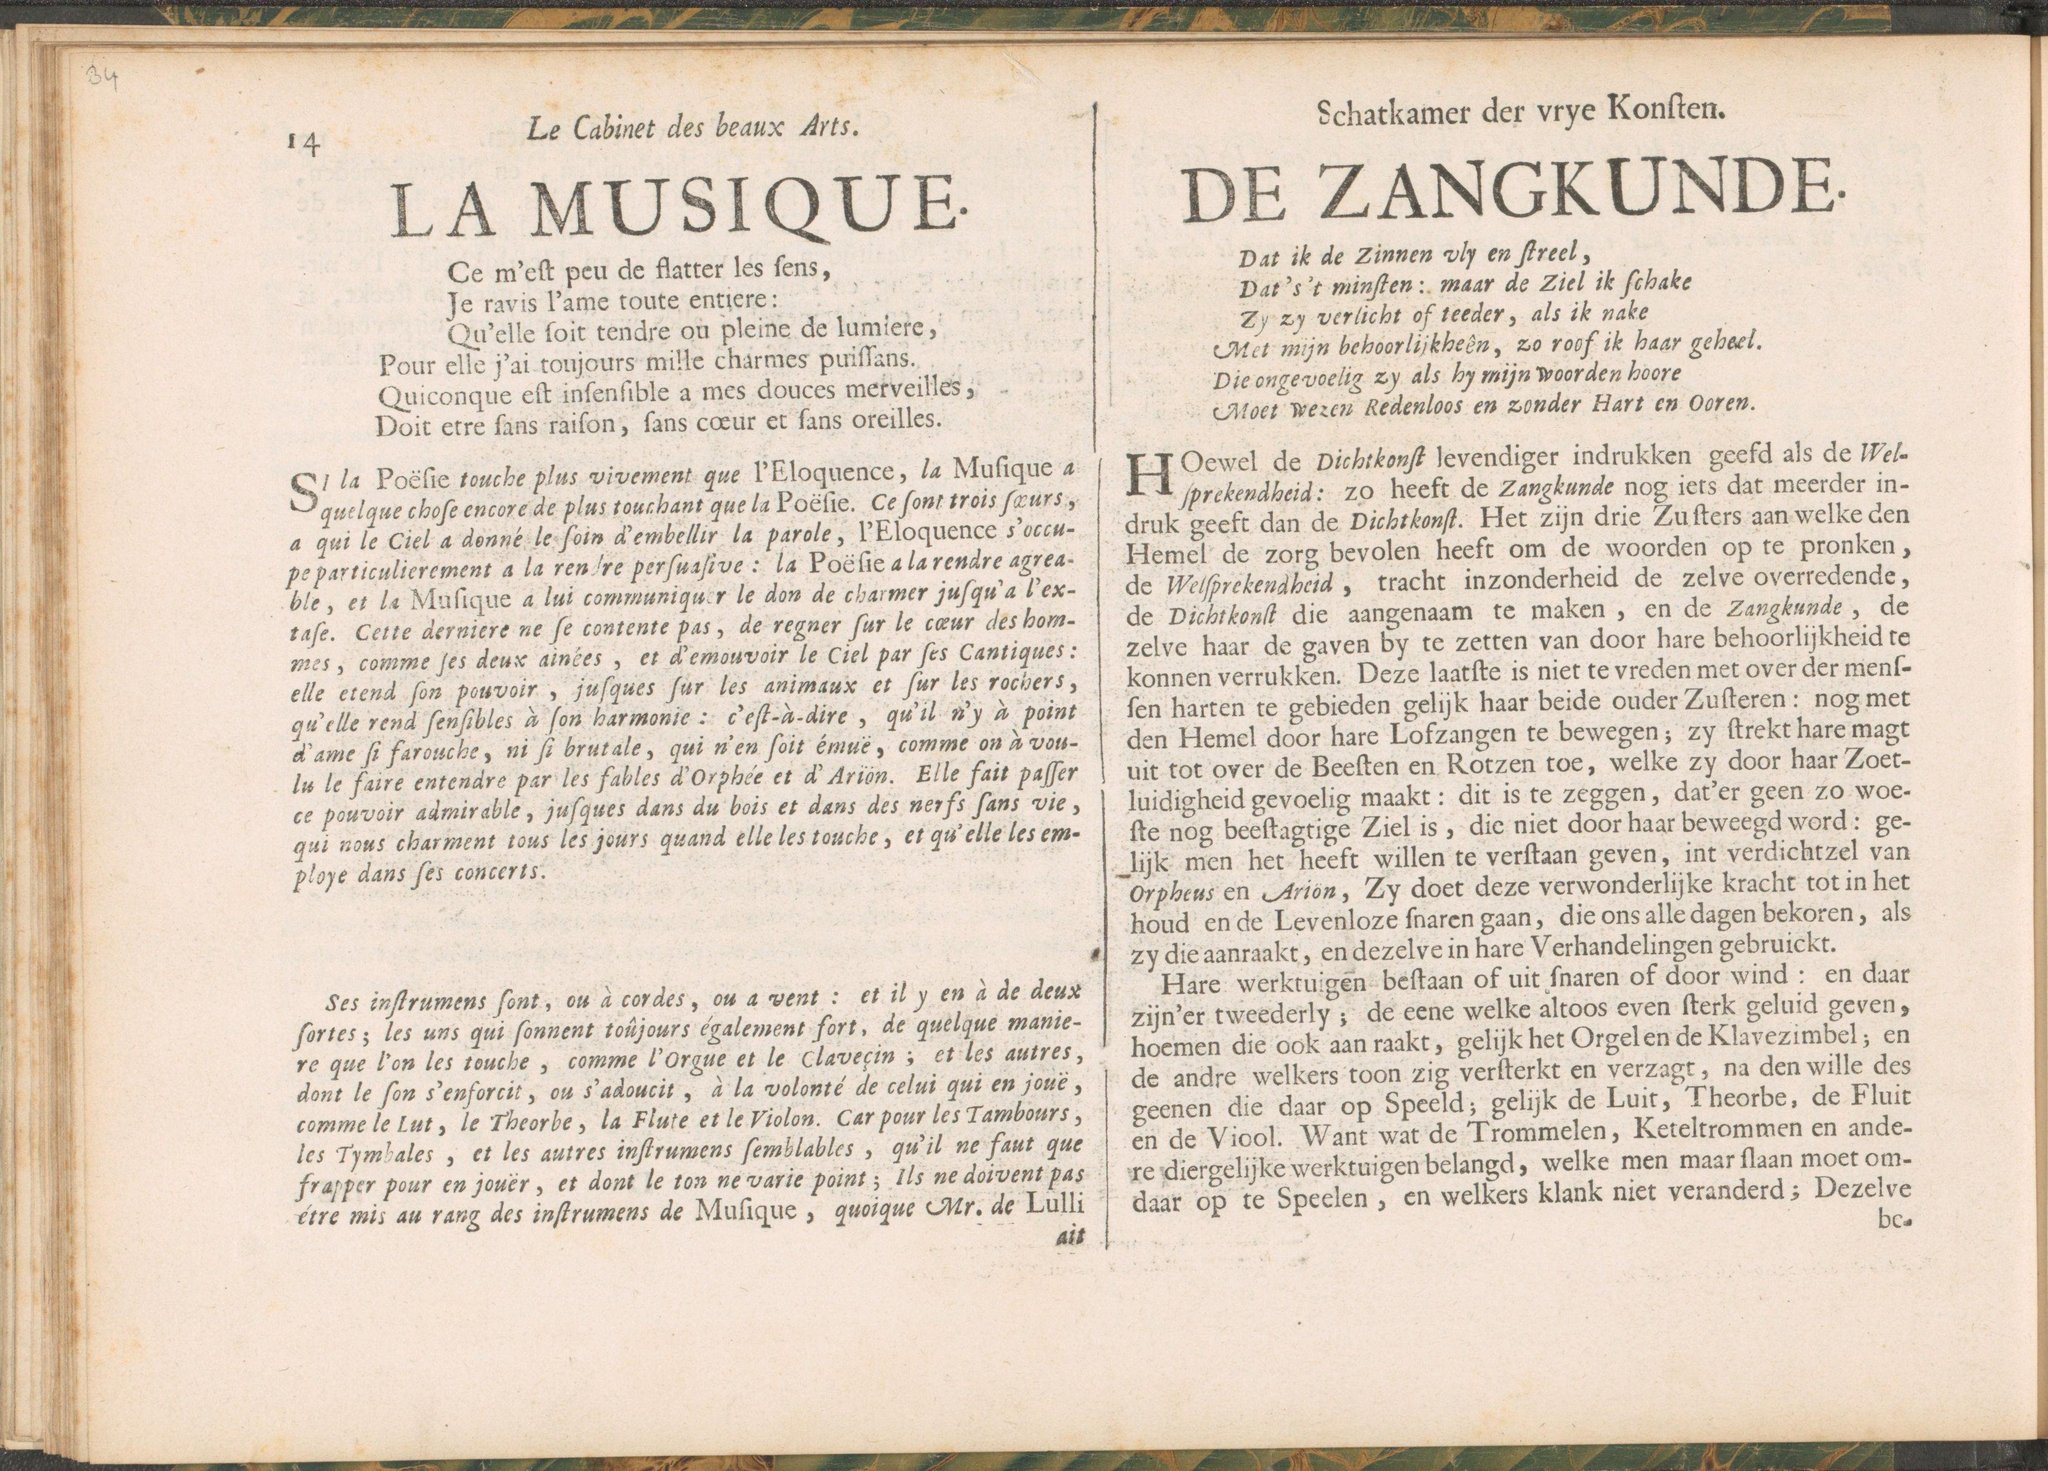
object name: text sheet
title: La Musique / De Zangkunde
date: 1693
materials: paper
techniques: letterpress printing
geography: amsterdam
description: Verklaring van de prent met de voorstelling van de personificatie van Muziek in het Frans en het Nederlands, pagina 14. Tekstblad maakt deel uit van een album.